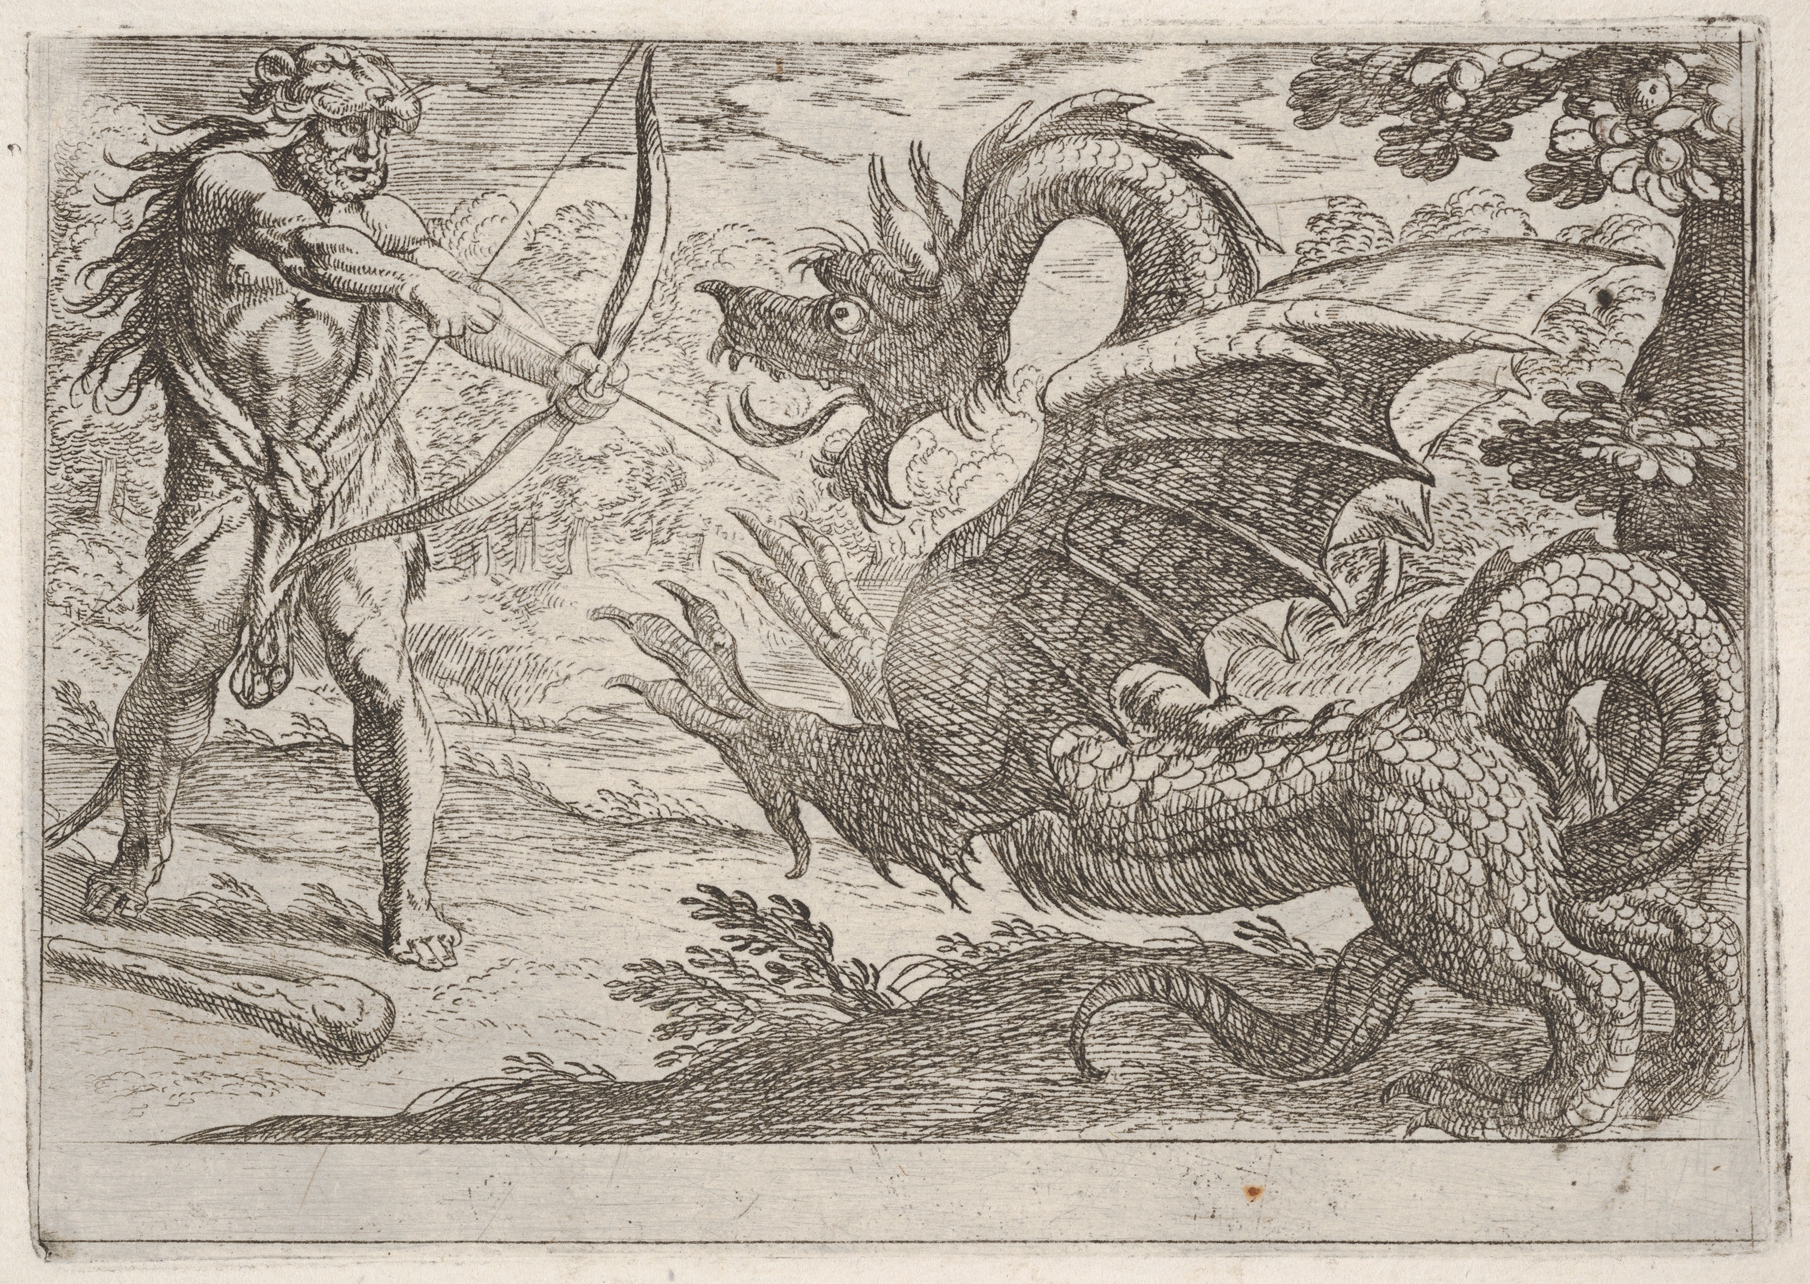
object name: print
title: Hercules and the Serpent Ladon, from "The Labors of Hercules"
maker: antonio tempesta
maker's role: artist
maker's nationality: italian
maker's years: 1555-1630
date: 1608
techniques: etching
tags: bow and arrow,hercules,dragons